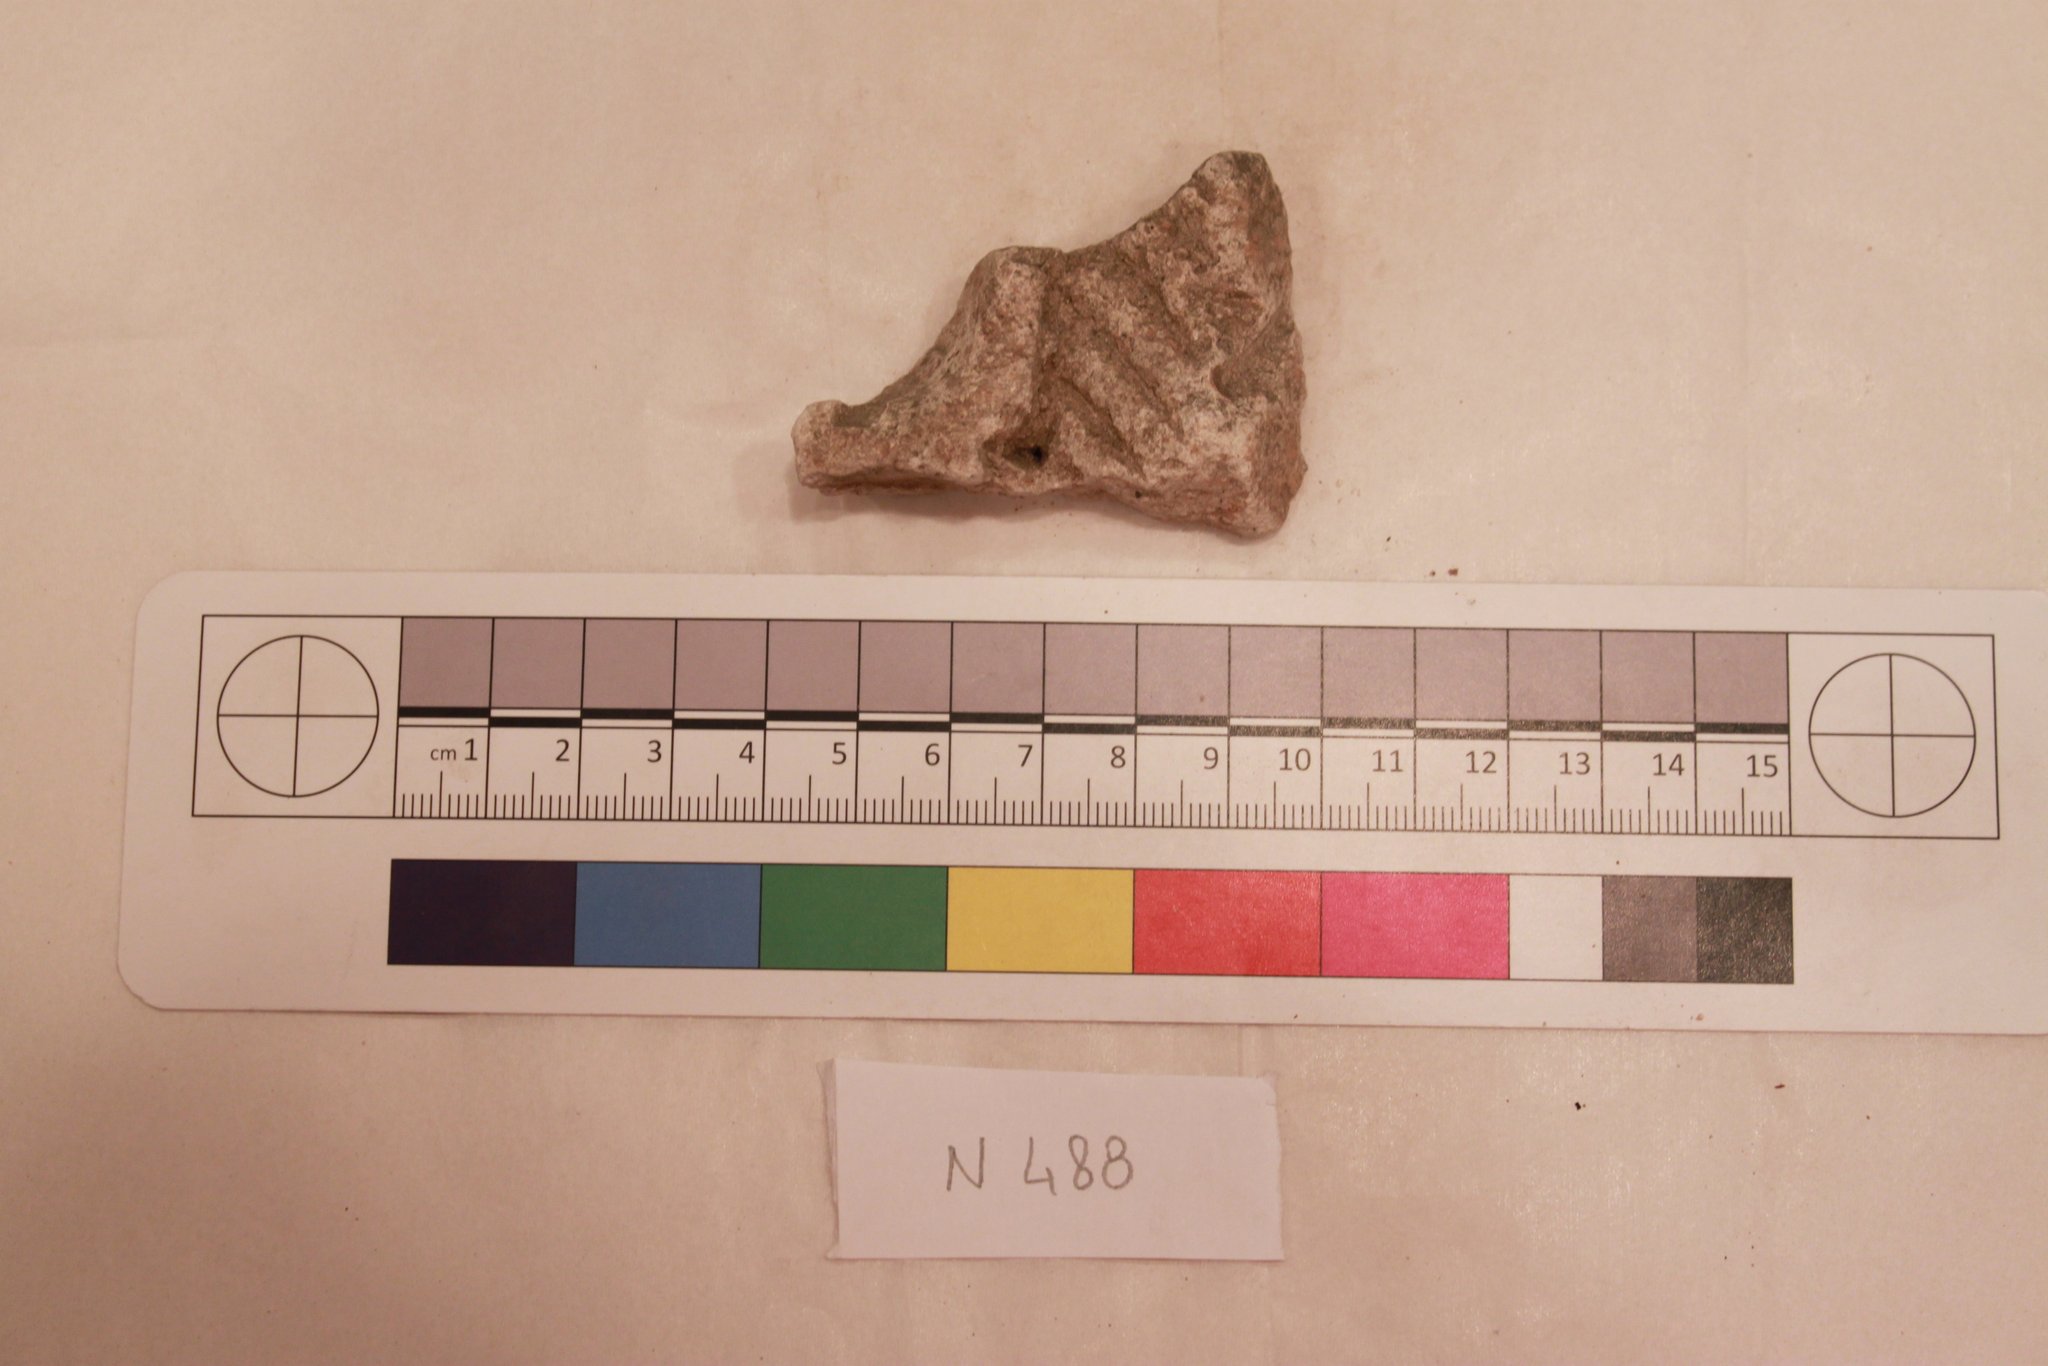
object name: fragment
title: Stucco Fragment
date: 701-1200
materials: plaster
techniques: carving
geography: iran